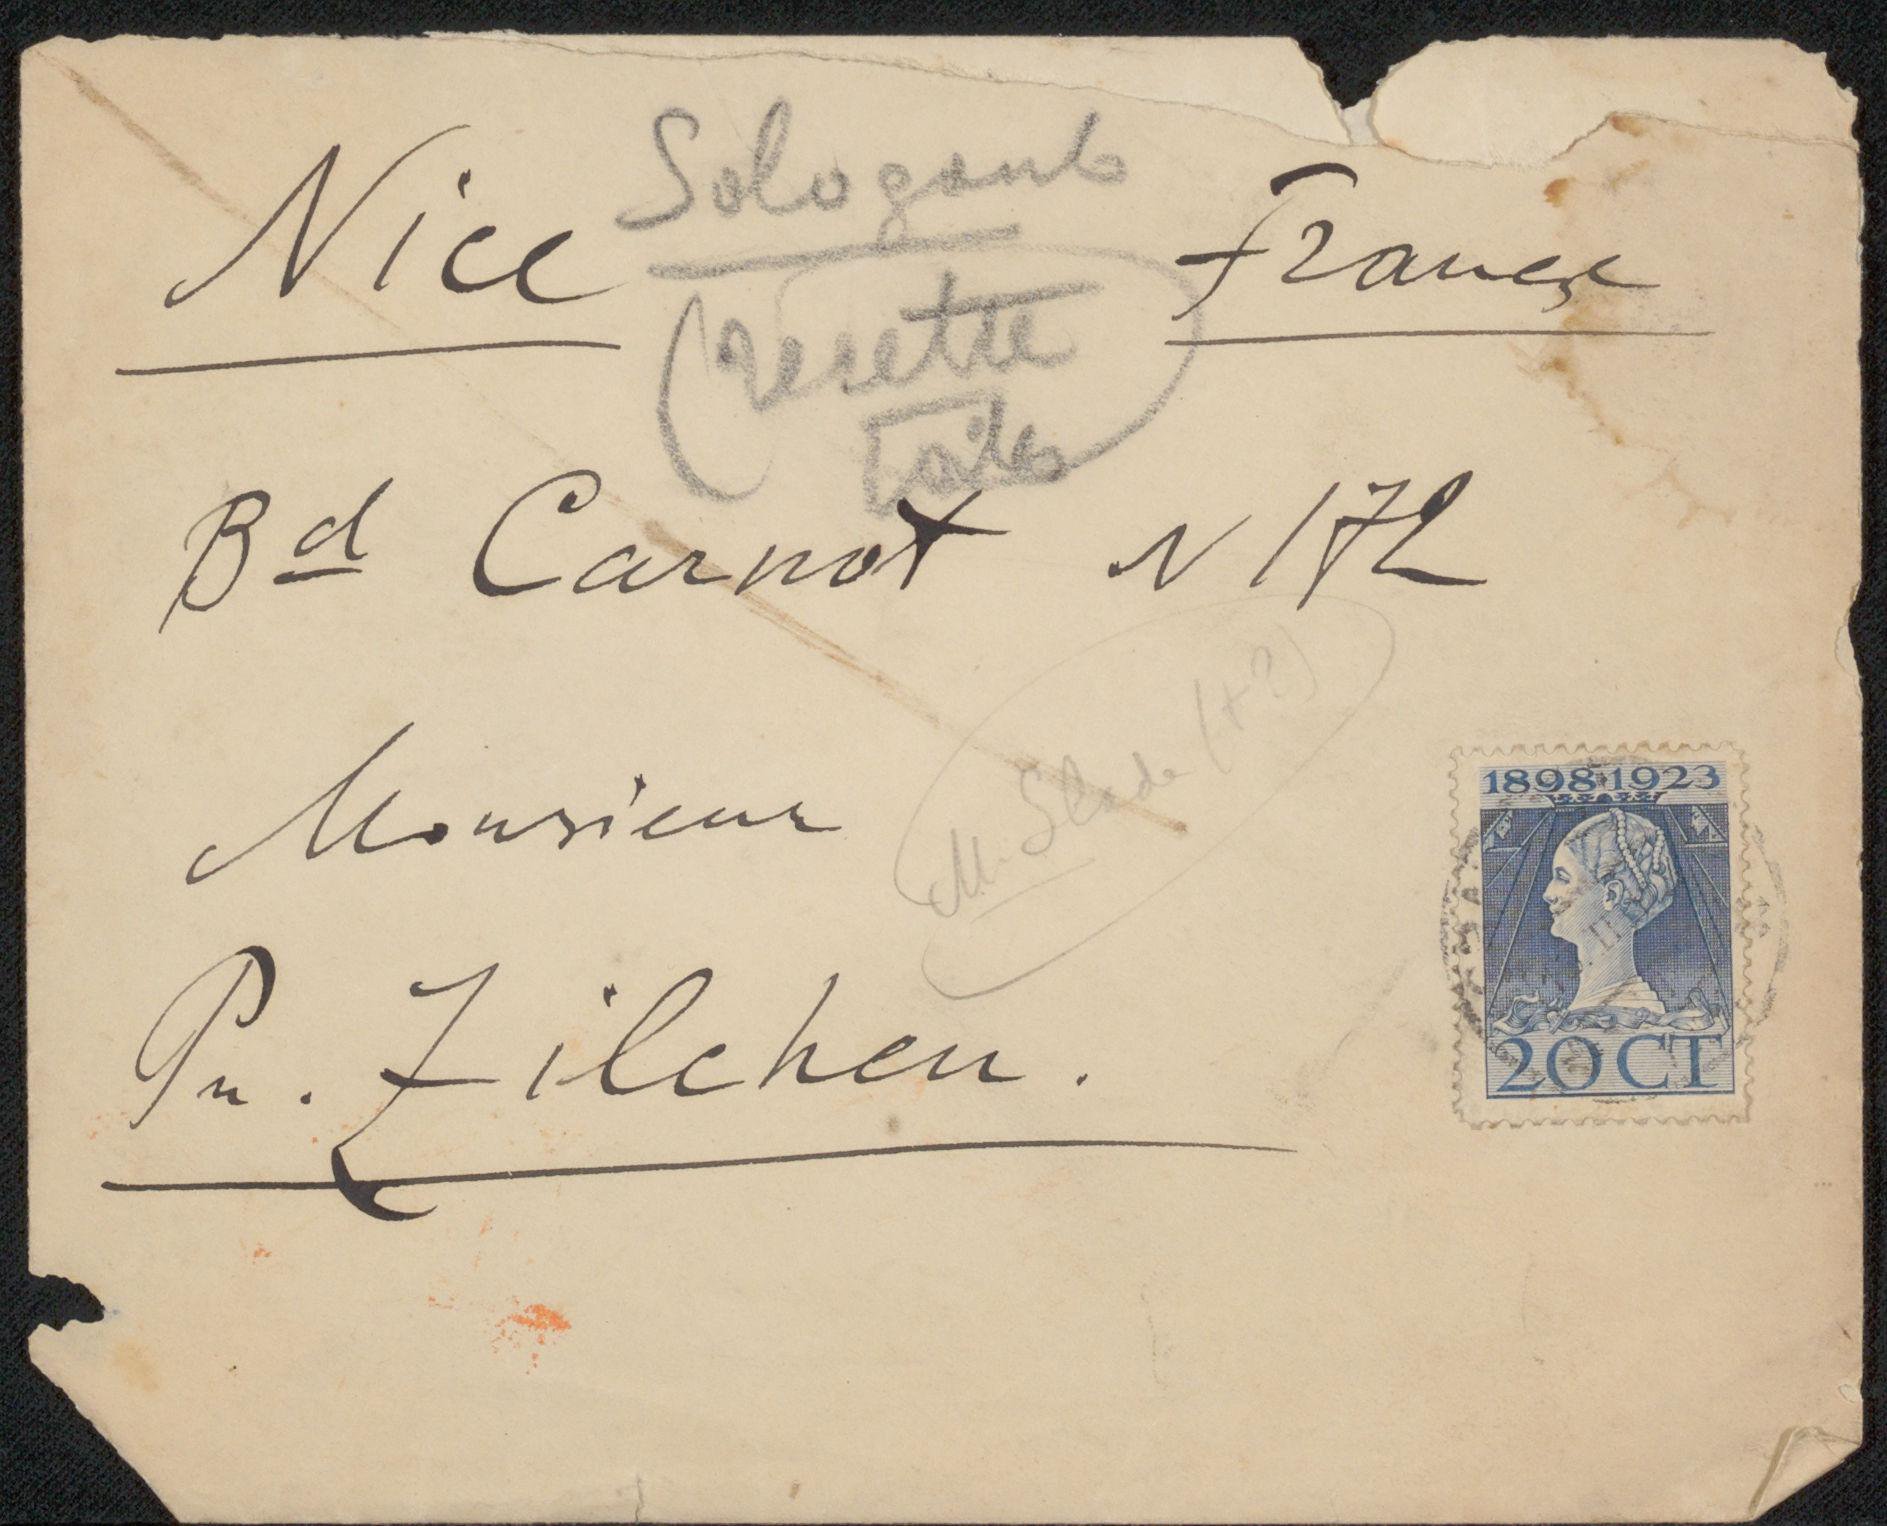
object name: envelope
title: Envelop aan Philip Zilcken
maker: leonid sologoub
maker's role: draughtsman, painter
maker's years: 1884-1956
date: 1894-1930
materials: ink, paper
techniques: pen, writing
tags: draughtsman, philip zilcken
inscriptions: collector's mark: ‘RPK’